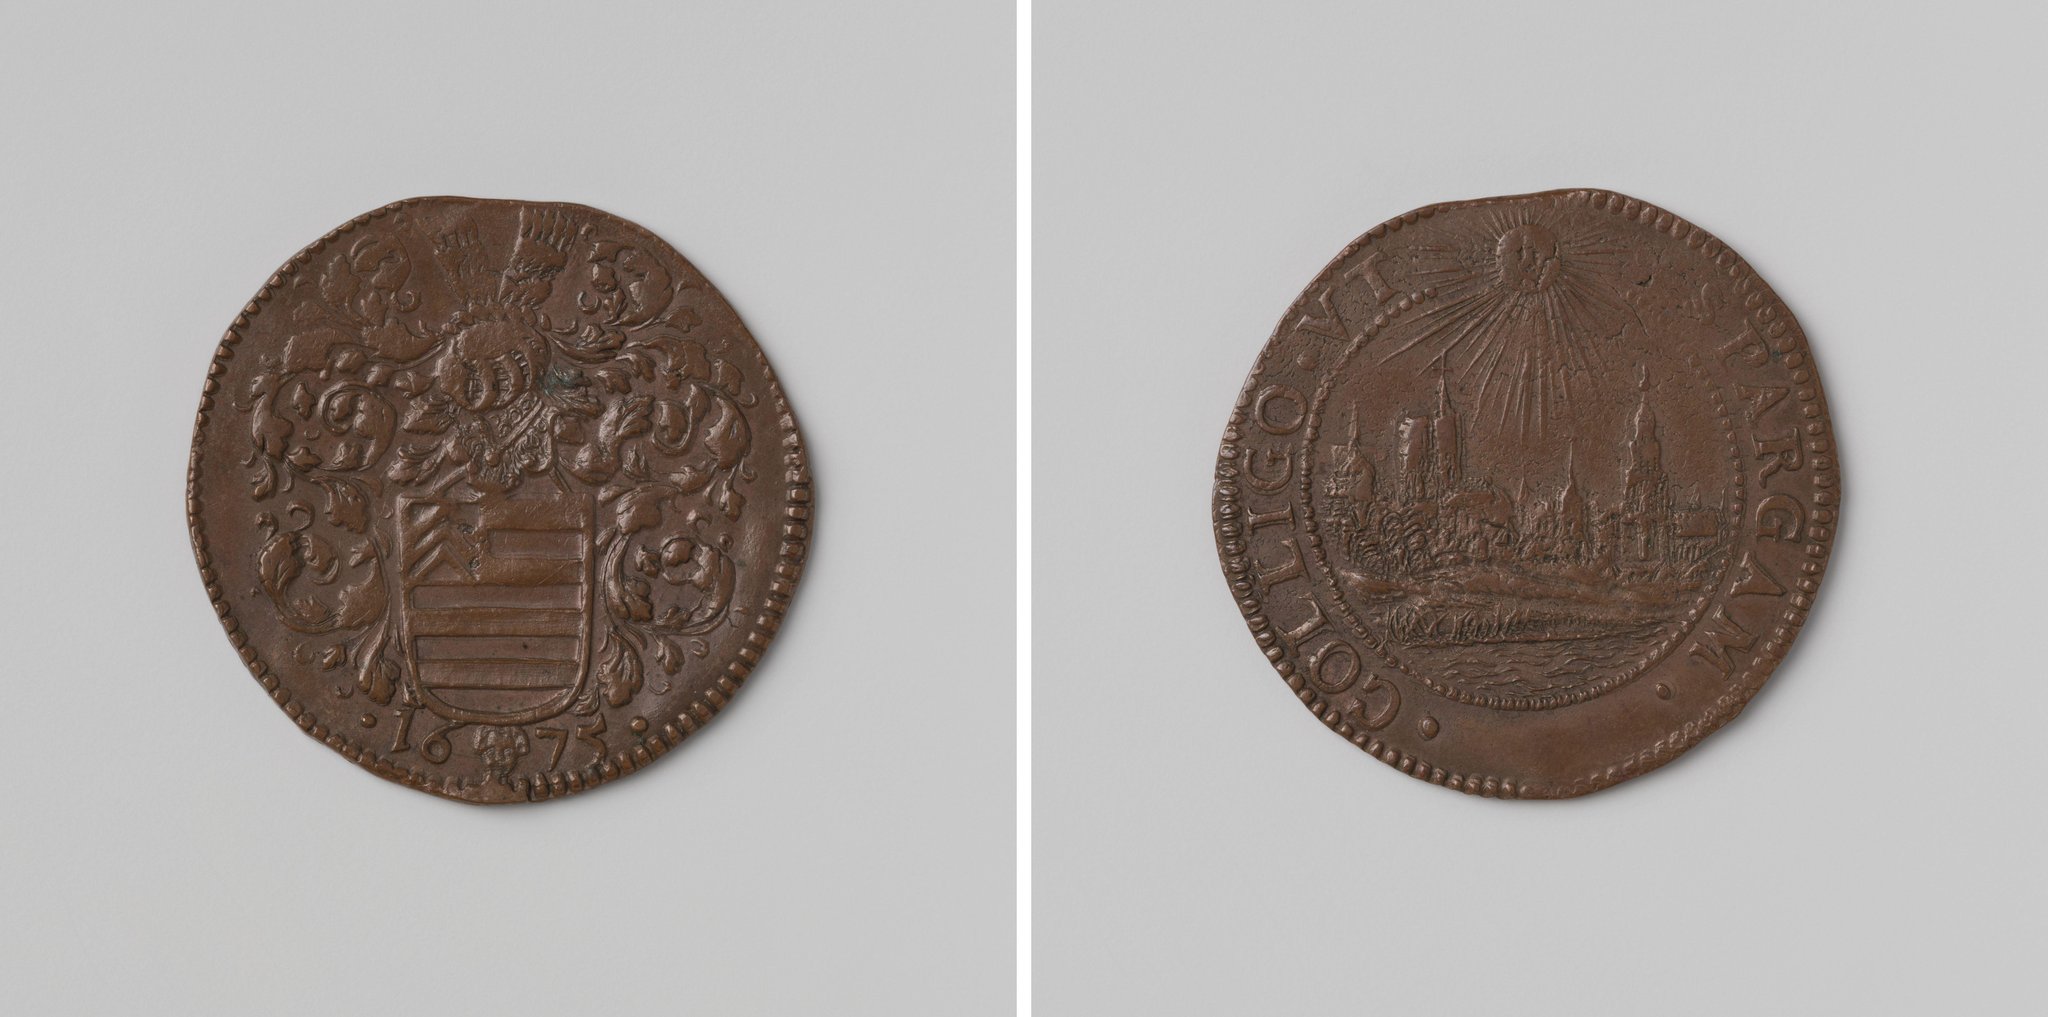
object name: jeton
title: Philippe Godefroid Vande Wouwere, magistraat van de schatkist van Brussel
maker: Anonymous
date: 1601-1675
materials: copper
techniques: striking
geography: brussels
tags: brussels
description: Koperen penning. Voorzijde: gehelmd wapenschild boven jaartal binnen omschrift. Keerzijde: gezicht op stad Brussel, beschenen door stralende zon binnen omschrift